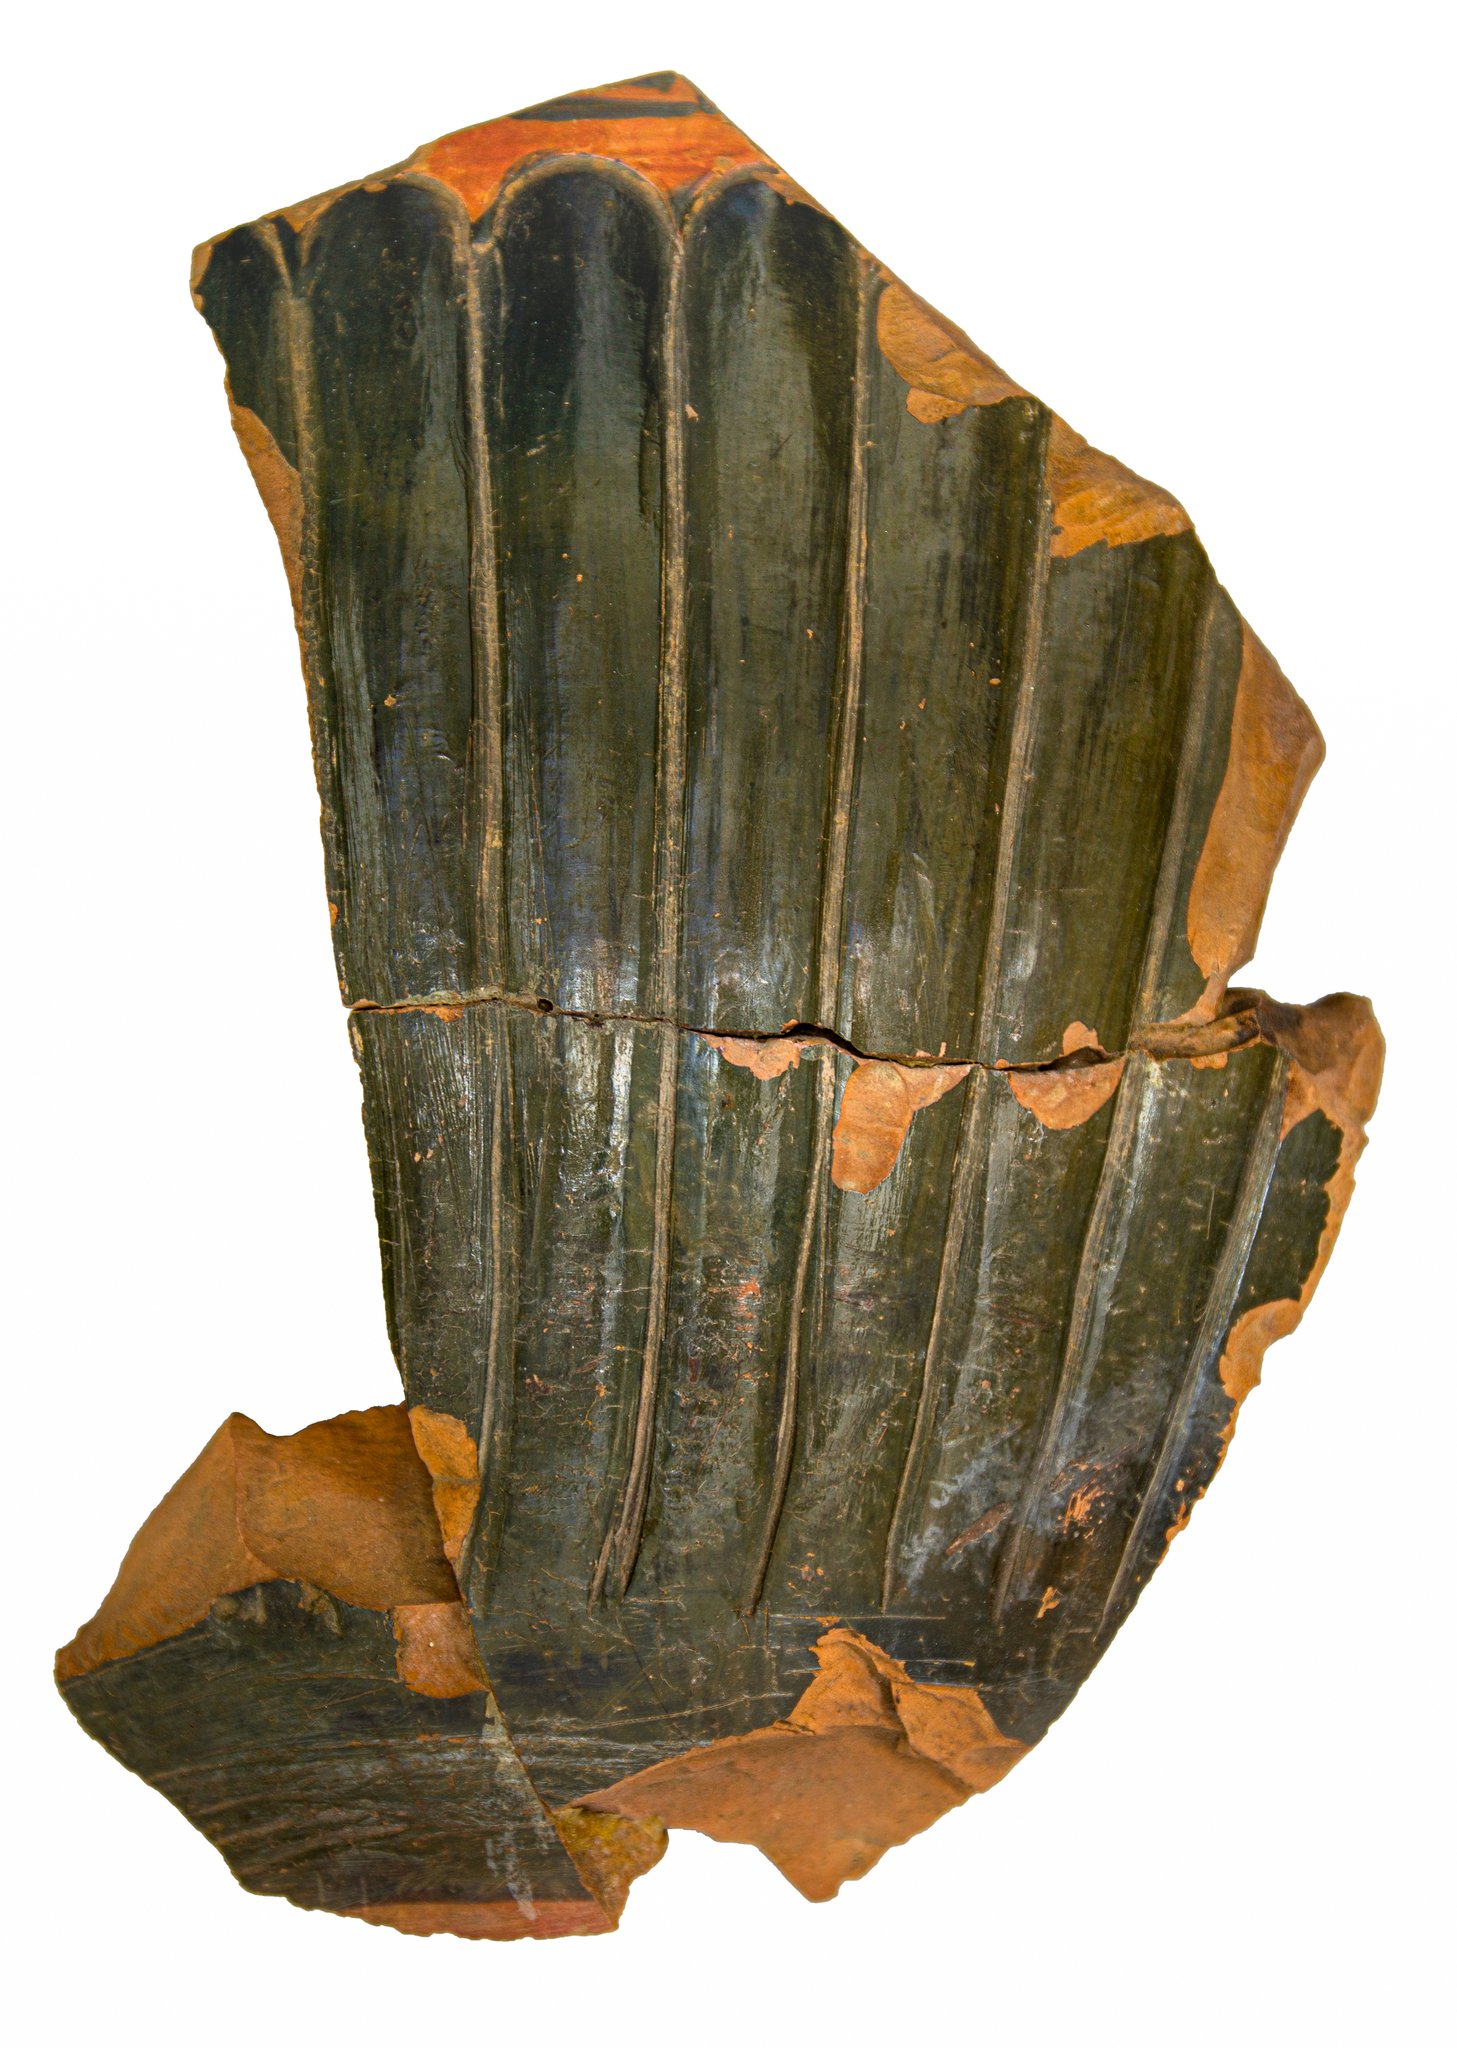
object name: volute krater fragment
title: Volute-krater fragment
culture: greek, south italian, apulian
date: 400-301 BCE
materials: terracotta